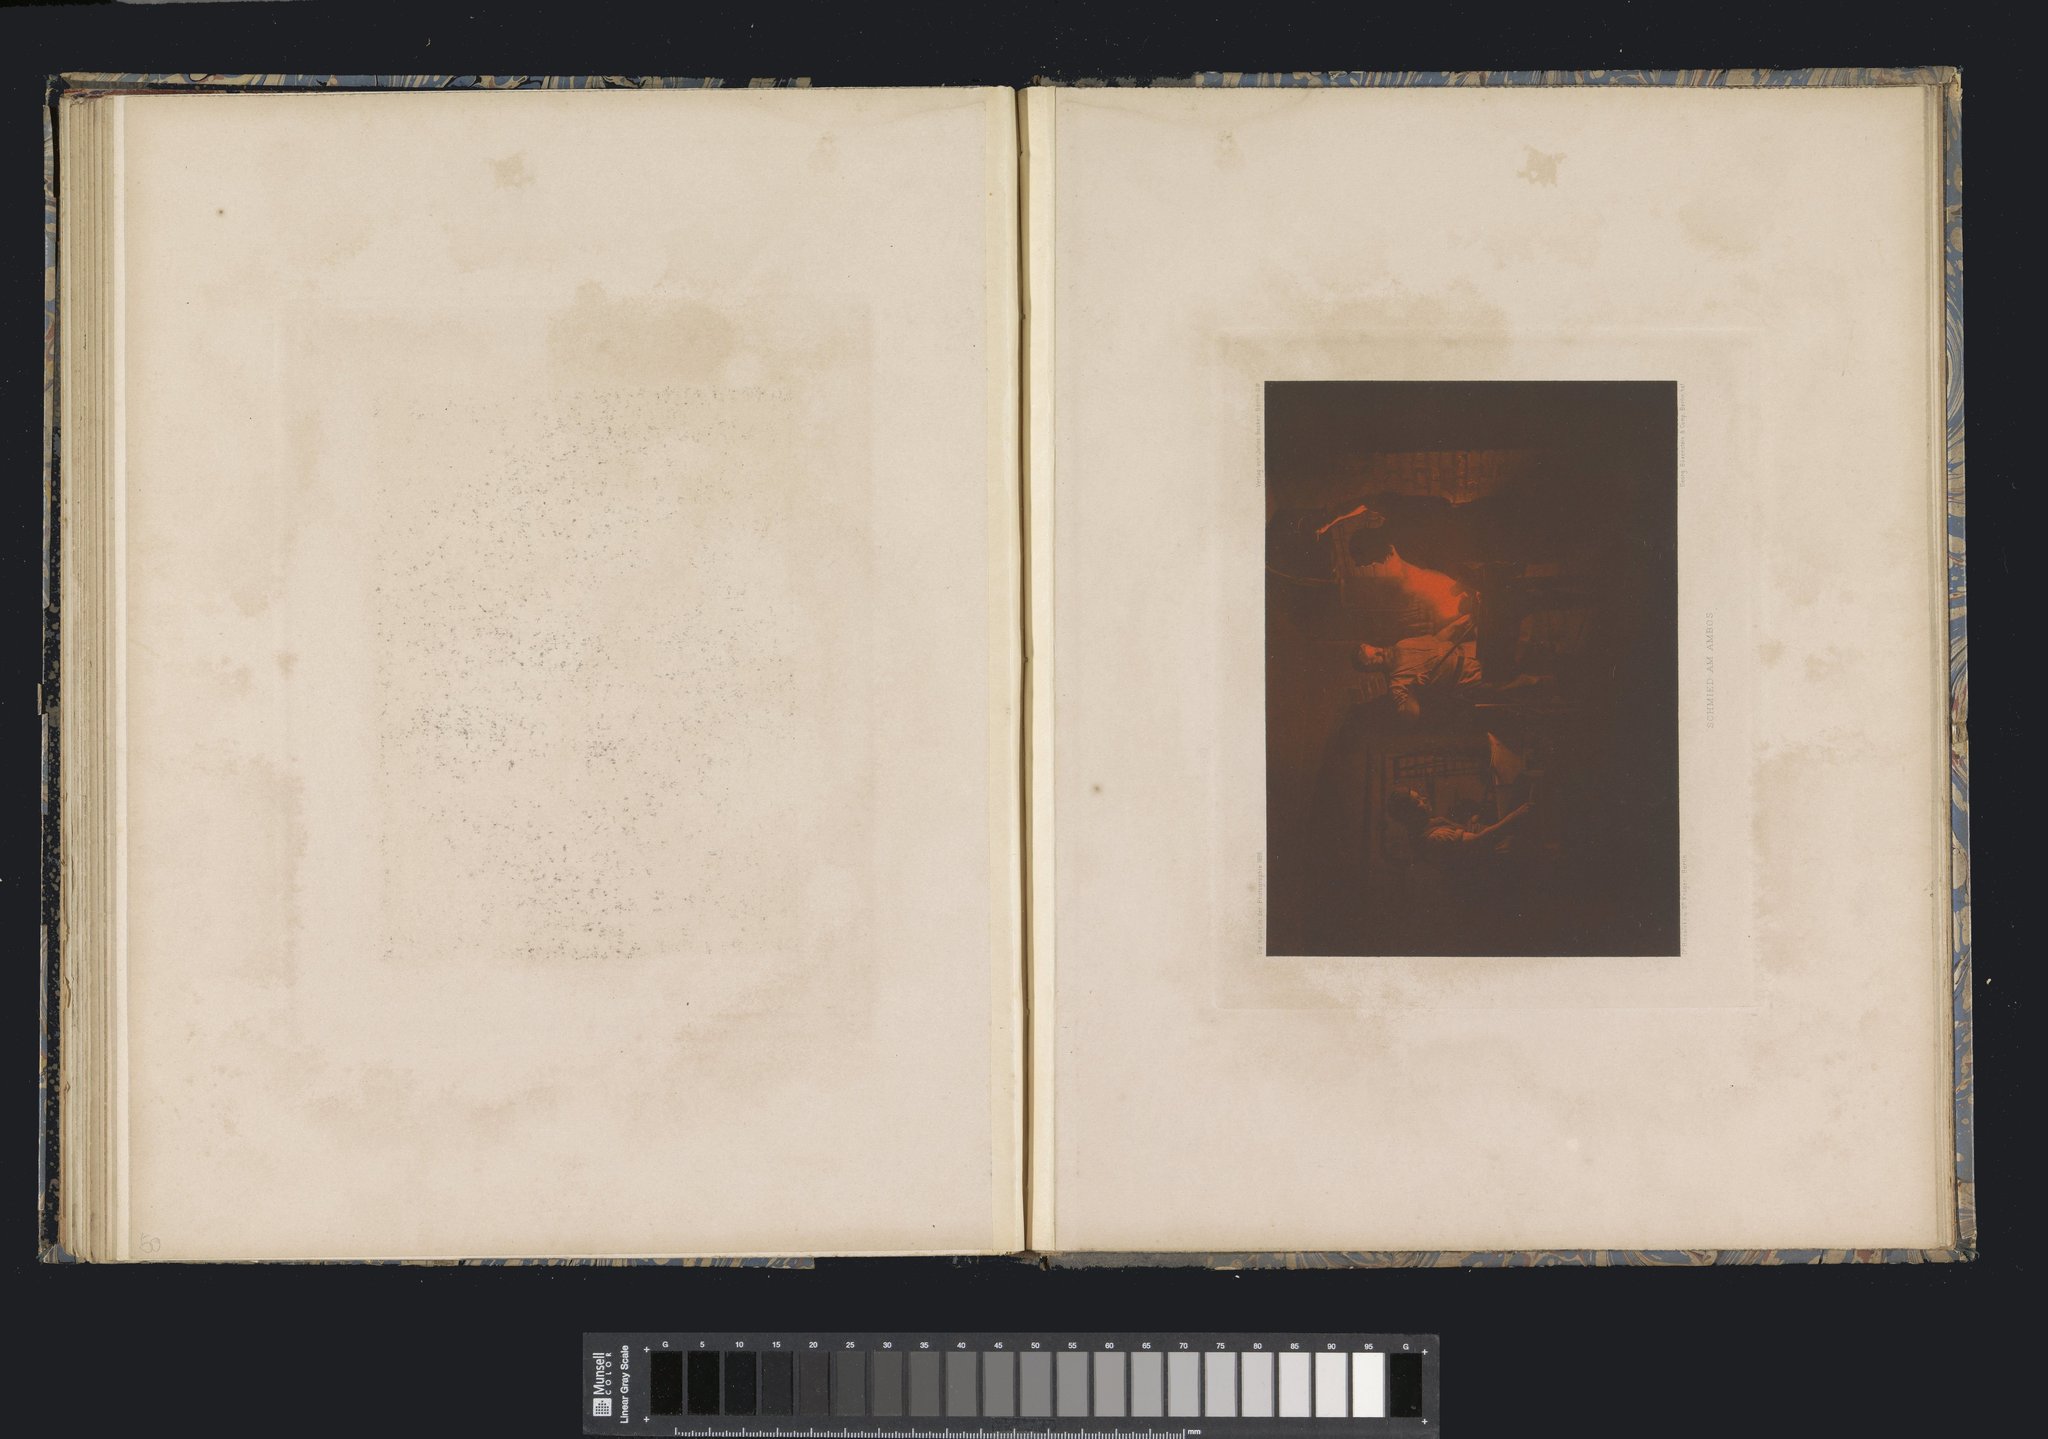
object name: photomechanical print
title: Schmied am Ambos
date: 1889-1899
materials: paper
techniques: photoaquatint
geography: germany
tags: smith, blacksmith, forging (industrial process)